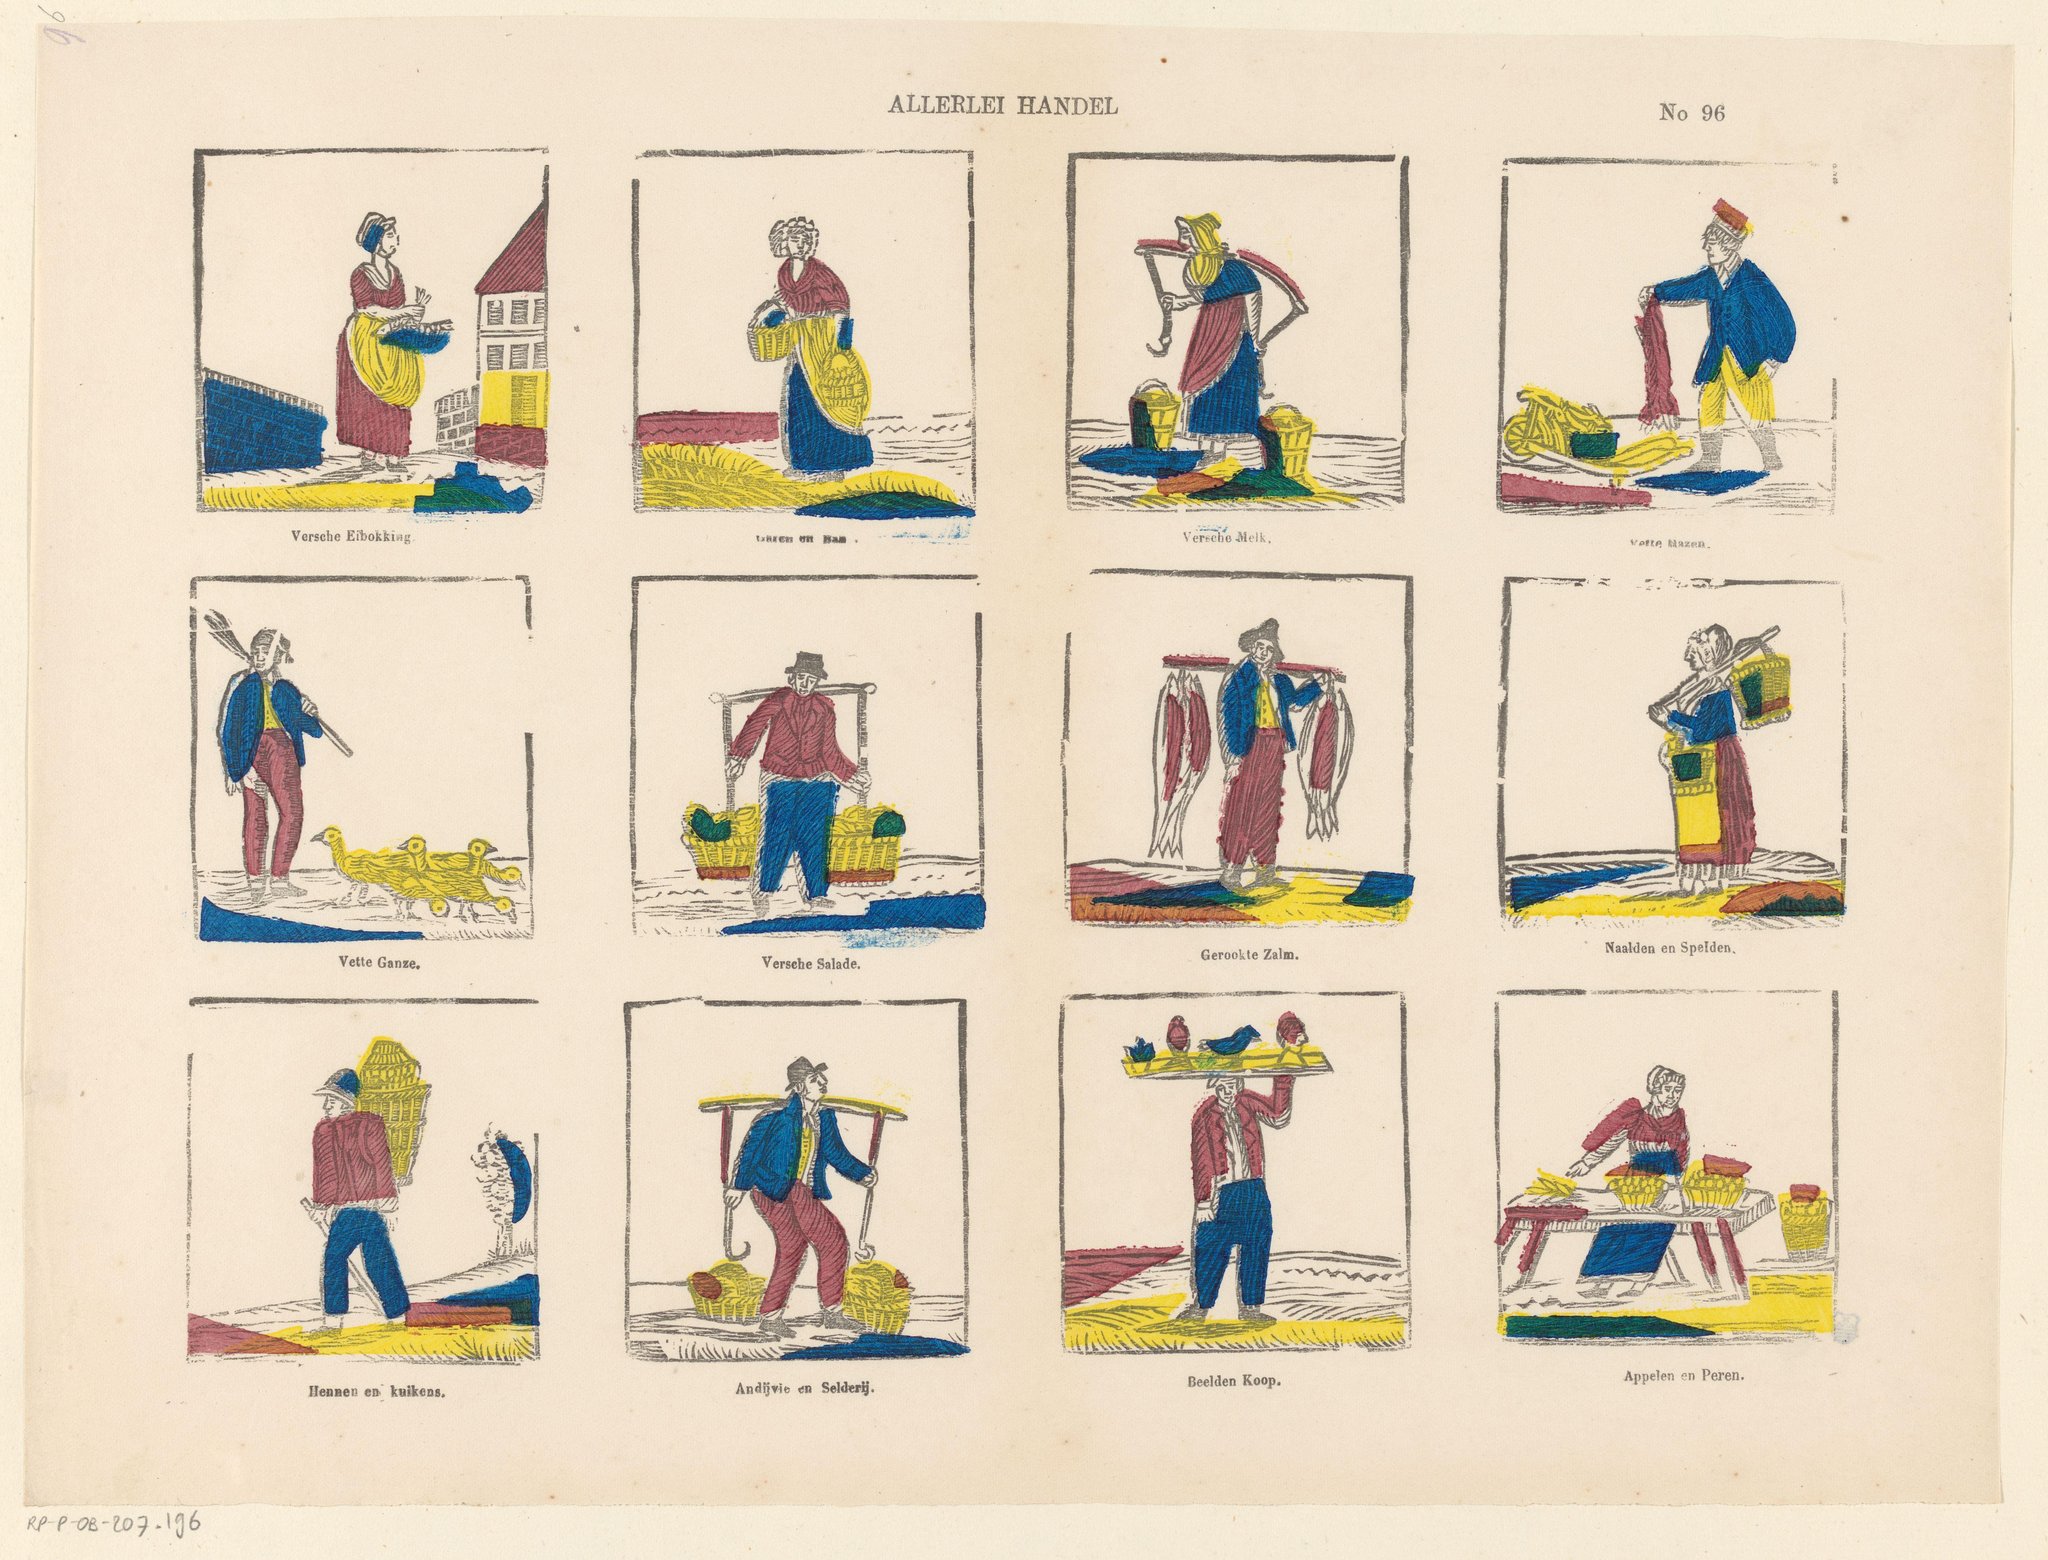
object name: print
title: Allerlei handel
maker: Anonymous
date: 1848-1881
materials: paper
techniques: colour, letterpress printing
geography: netherlands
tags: street-trader, merchant, salesman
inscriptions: collector's mark: Lugt 2760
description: Blad met 12 voorstellingen van straatverkopers. Onder elke afbeelding een onderschrift. Rechtsboven genummerd: No 96.